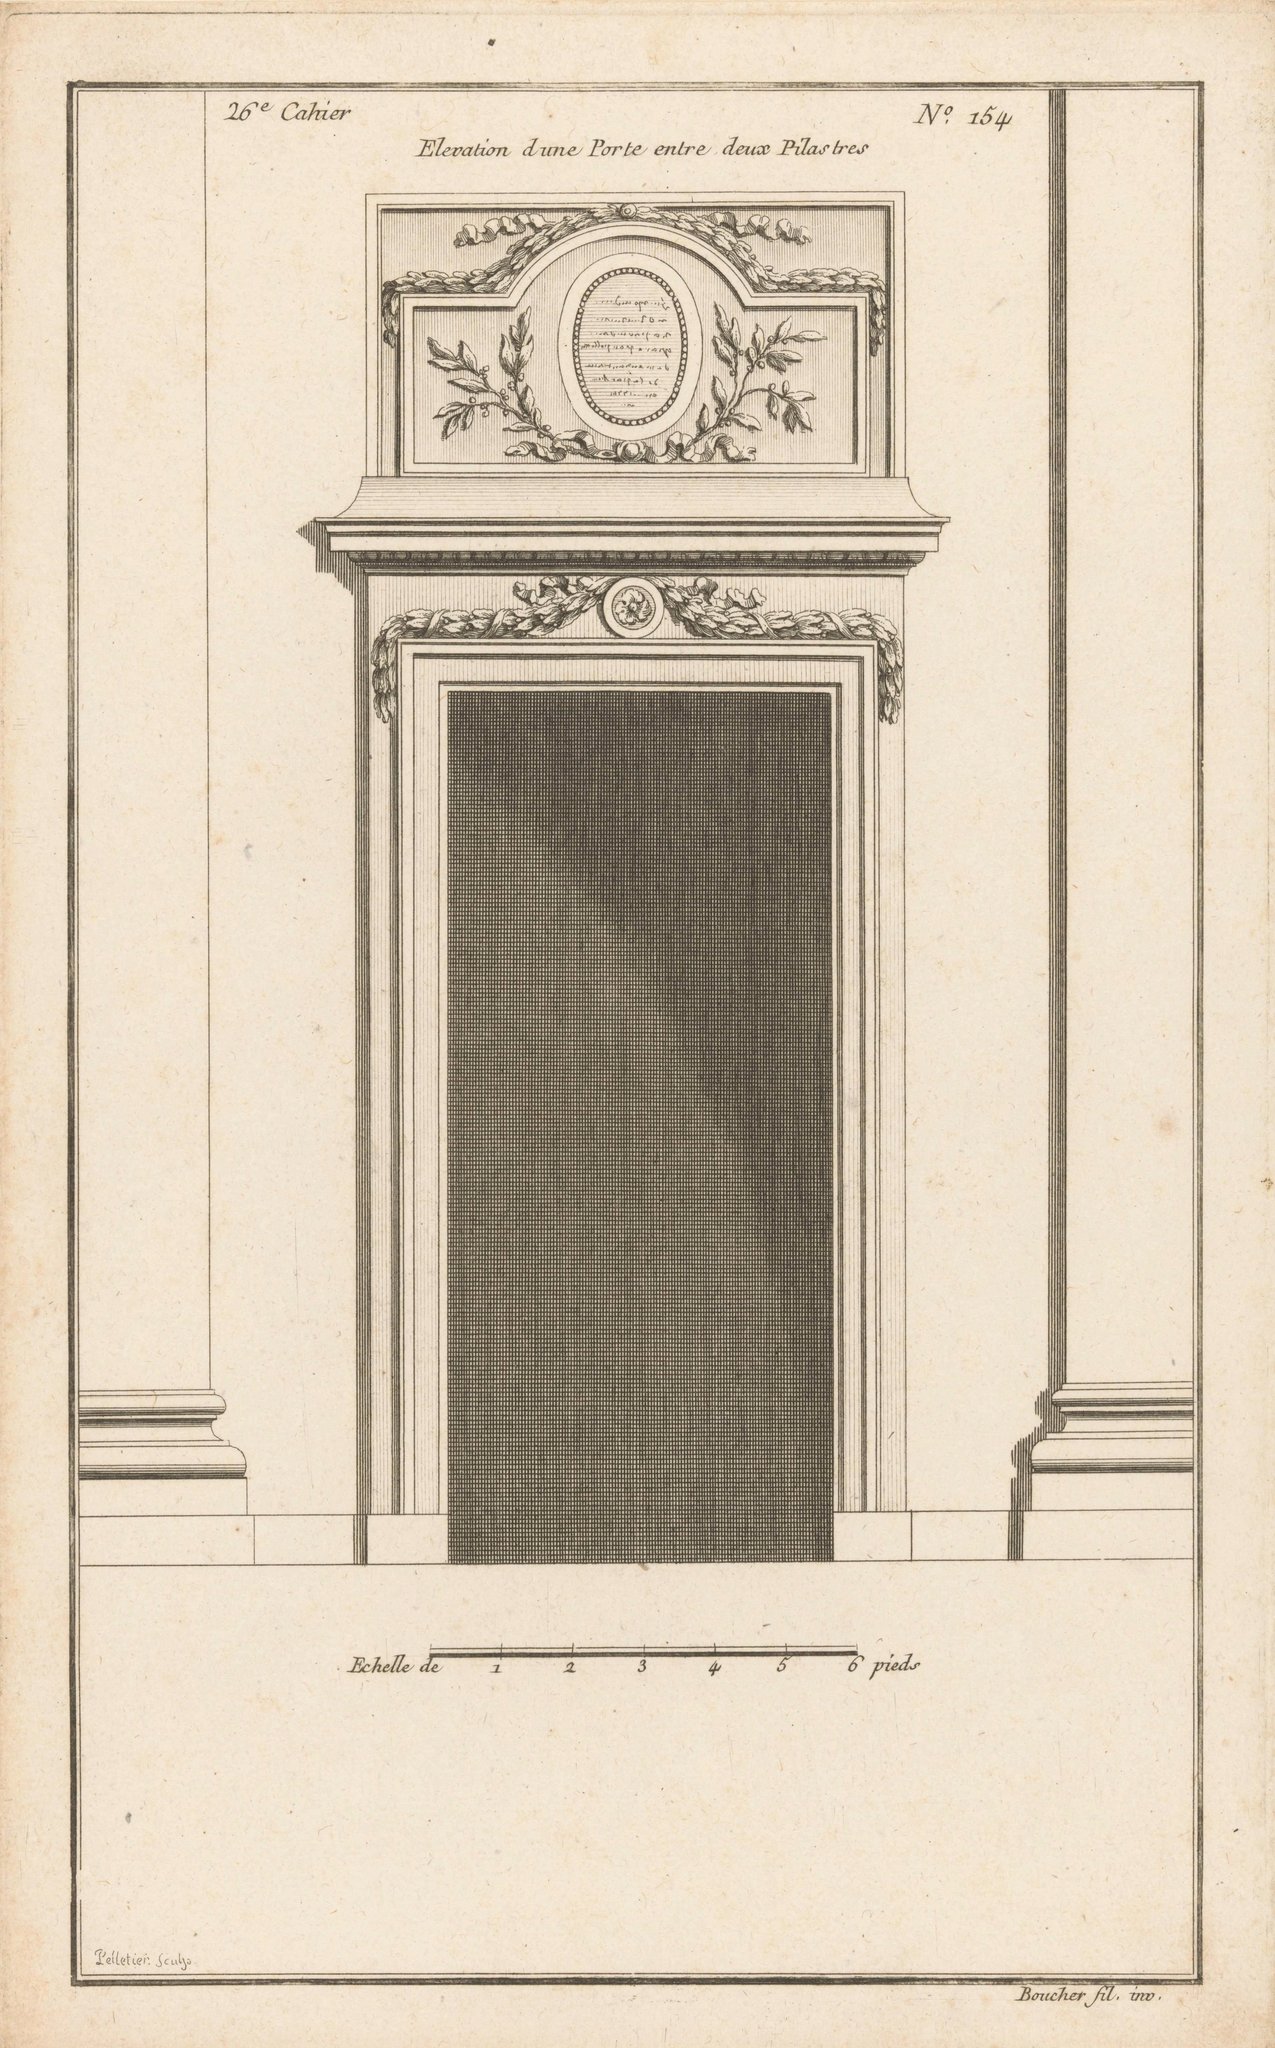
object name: ornament print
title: Deuren en portalen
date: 1772-1779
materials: paper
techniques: engraving, etching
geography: paris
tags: monumental door, porch, 'aediculum', ornament ~ medallion, half-column, pilaster ~ architecture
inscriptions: collector's mark: Lugt 2228, collector's mark: Lugt 2760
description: Een portaal met bladmotieven, daarboven een paneel met een ovaal medaillon en ranken. Aan weerszijden van het portaal zijn twee pilasters weergegeven. Prentnummer 154.